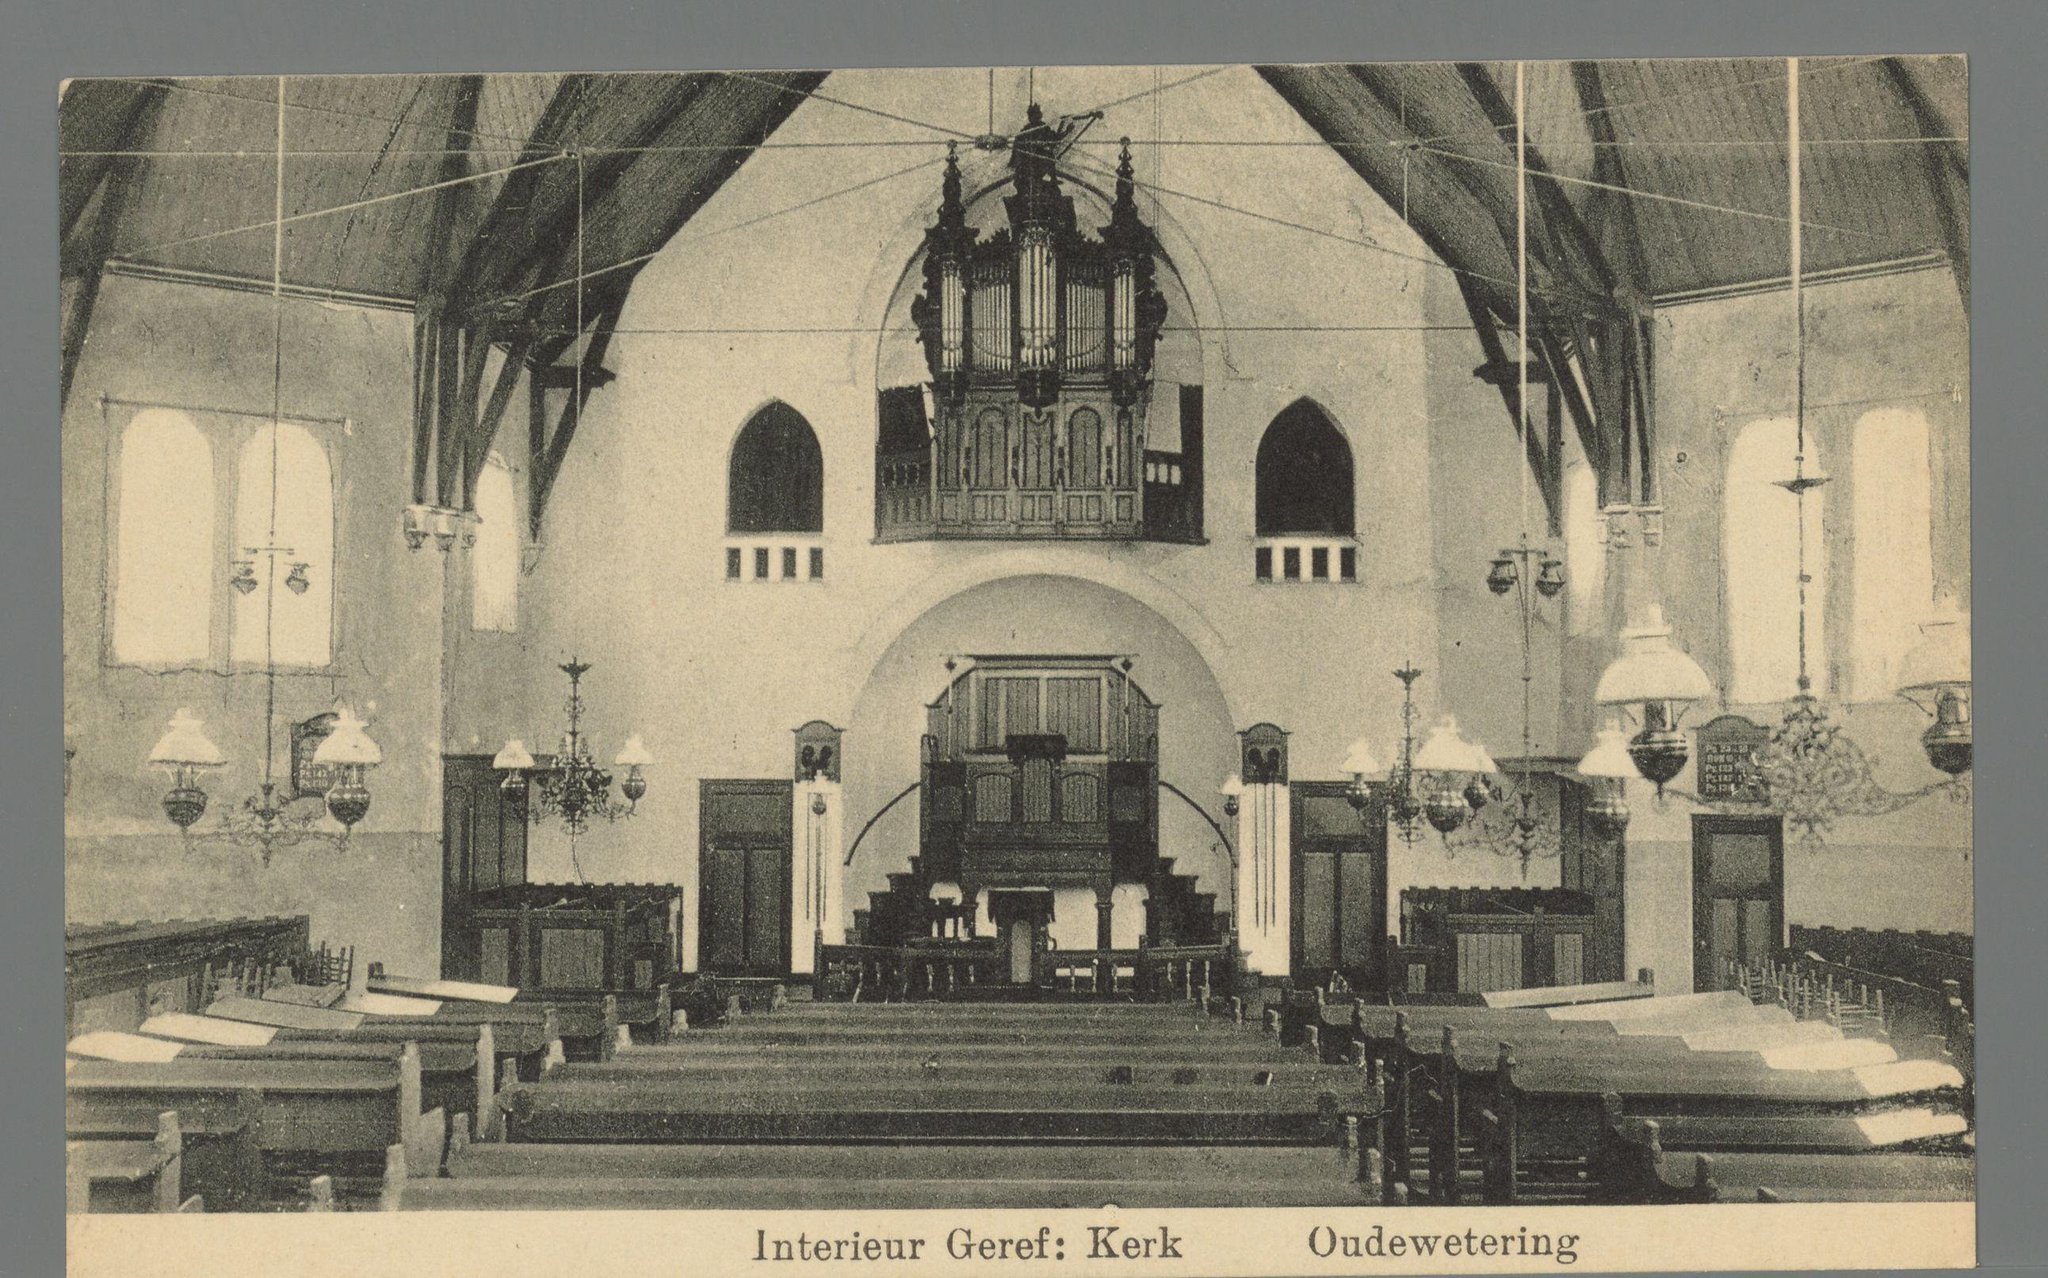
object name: photomechanical print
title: Interieur Geref: Kerk. Oudewetering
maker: Anonymous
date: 1905-1930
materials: cardboard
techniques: photograph, writing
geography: berlin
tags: interior of church